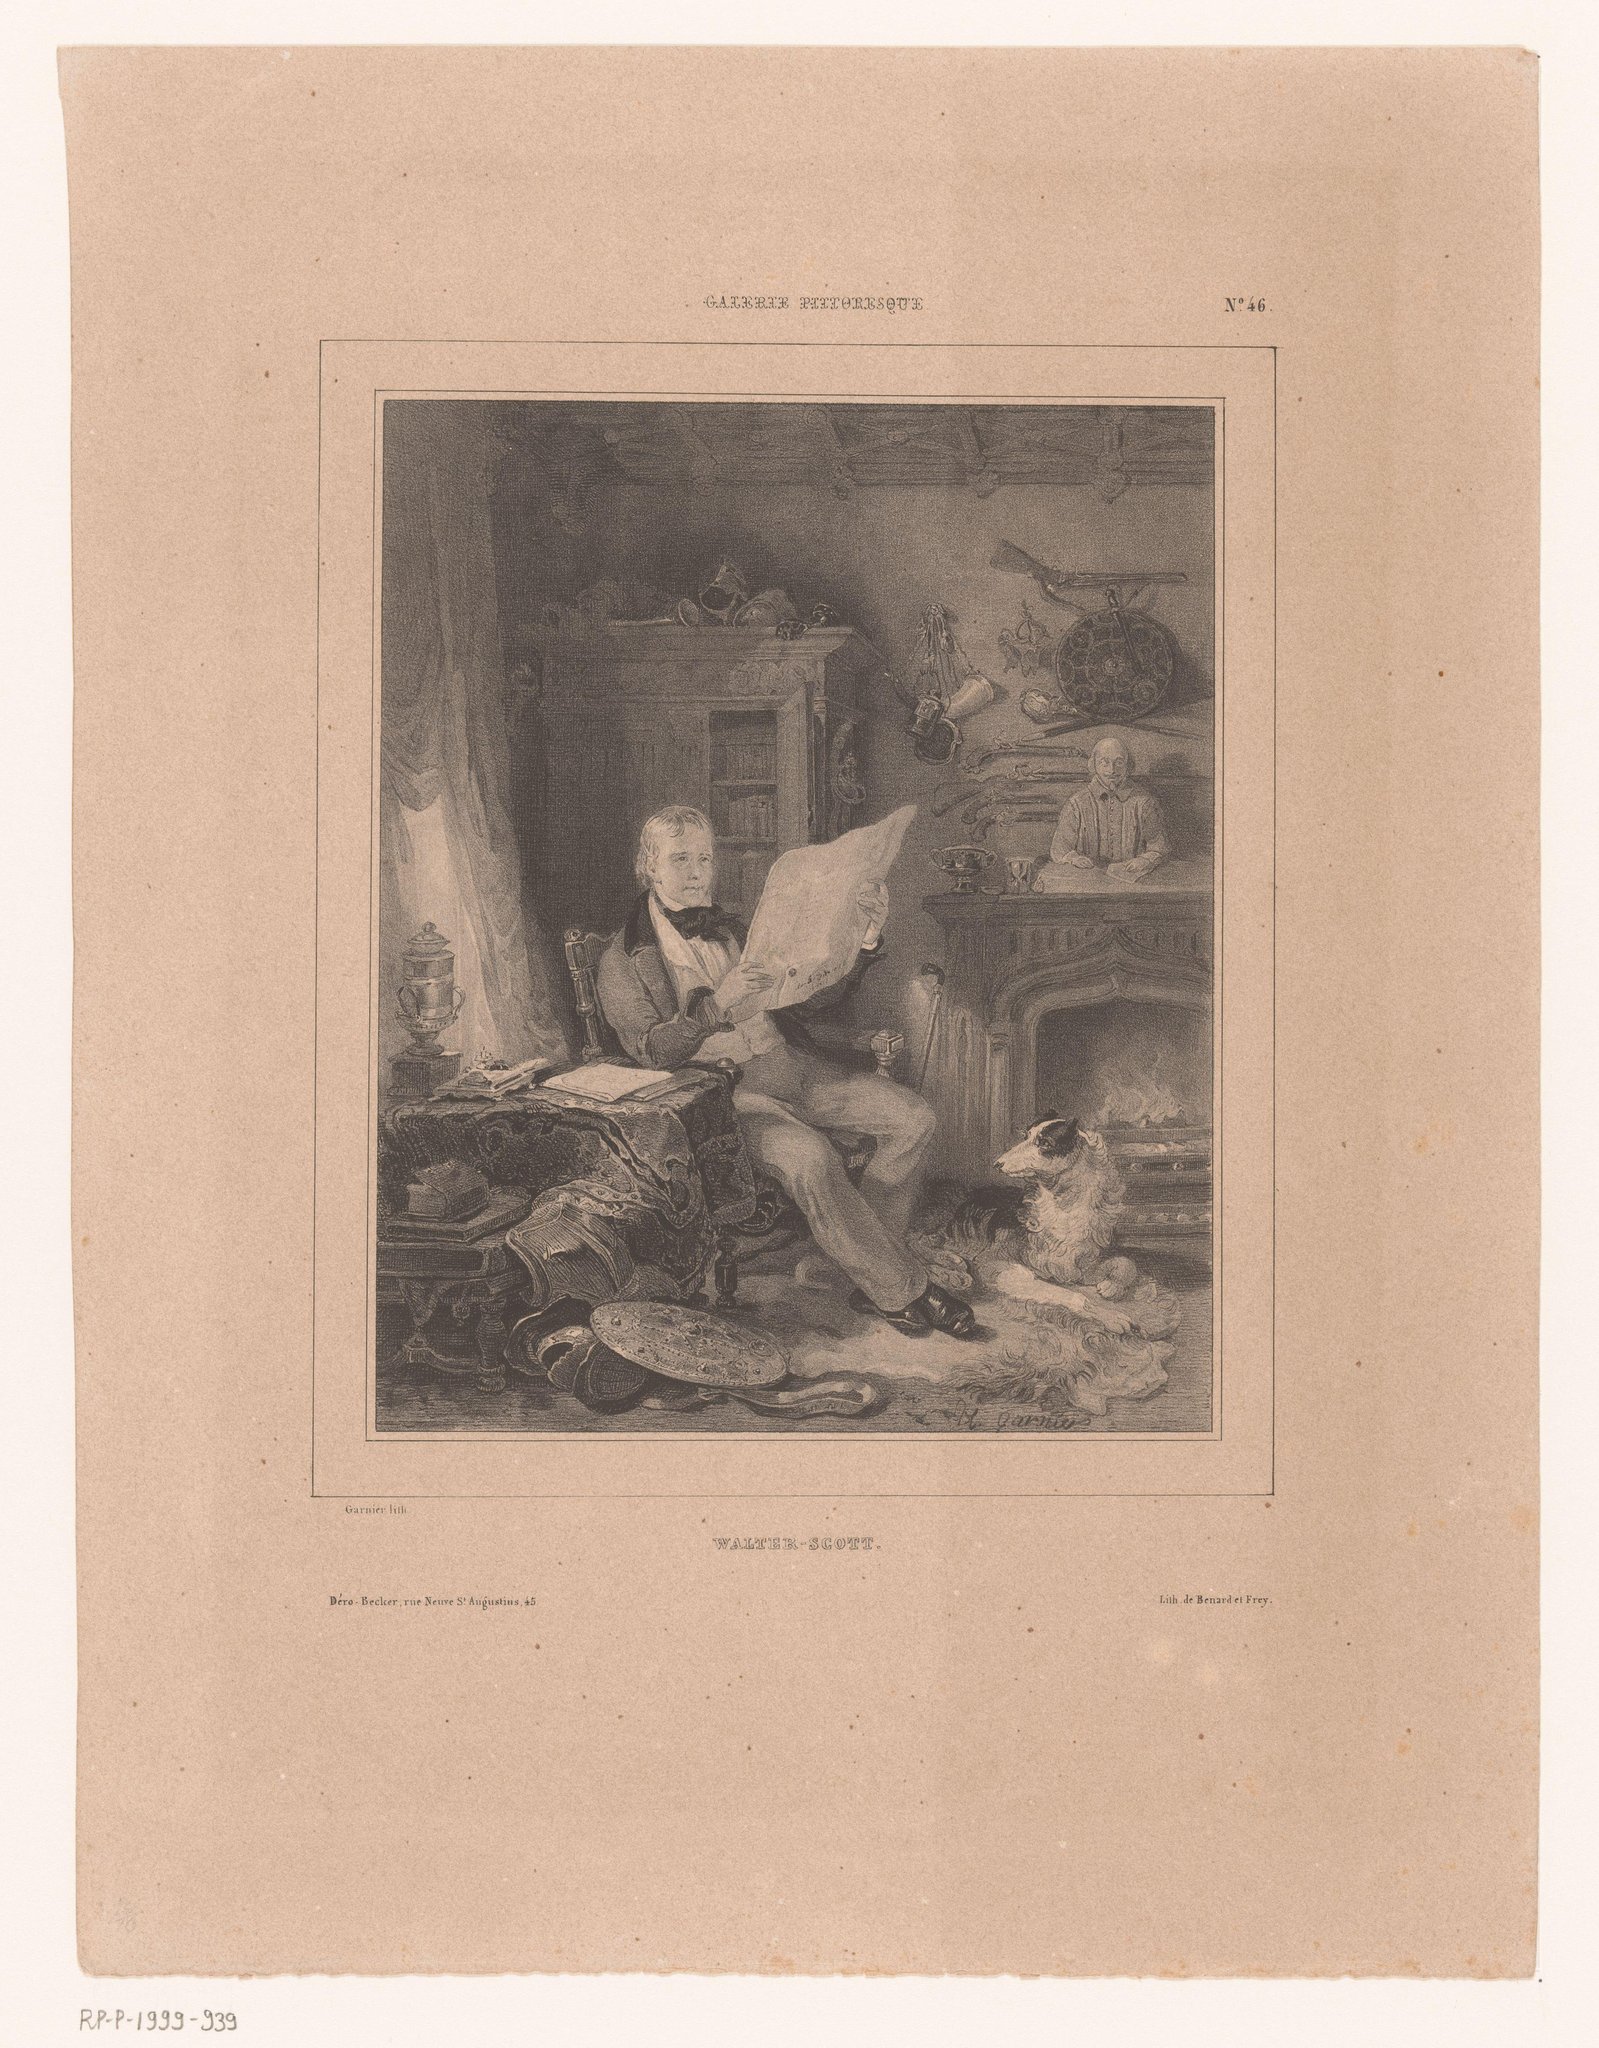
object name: print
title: Portret van Walter Scott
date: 1827-1839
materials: paper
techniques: lithograph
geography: paris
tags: walter scott, historical persons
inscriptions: collector's mark: Lugt 2760, collector's mark: Lugt 2228a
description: Walter Scott, zittend in interieur voor de open haard, een papier in de handen.